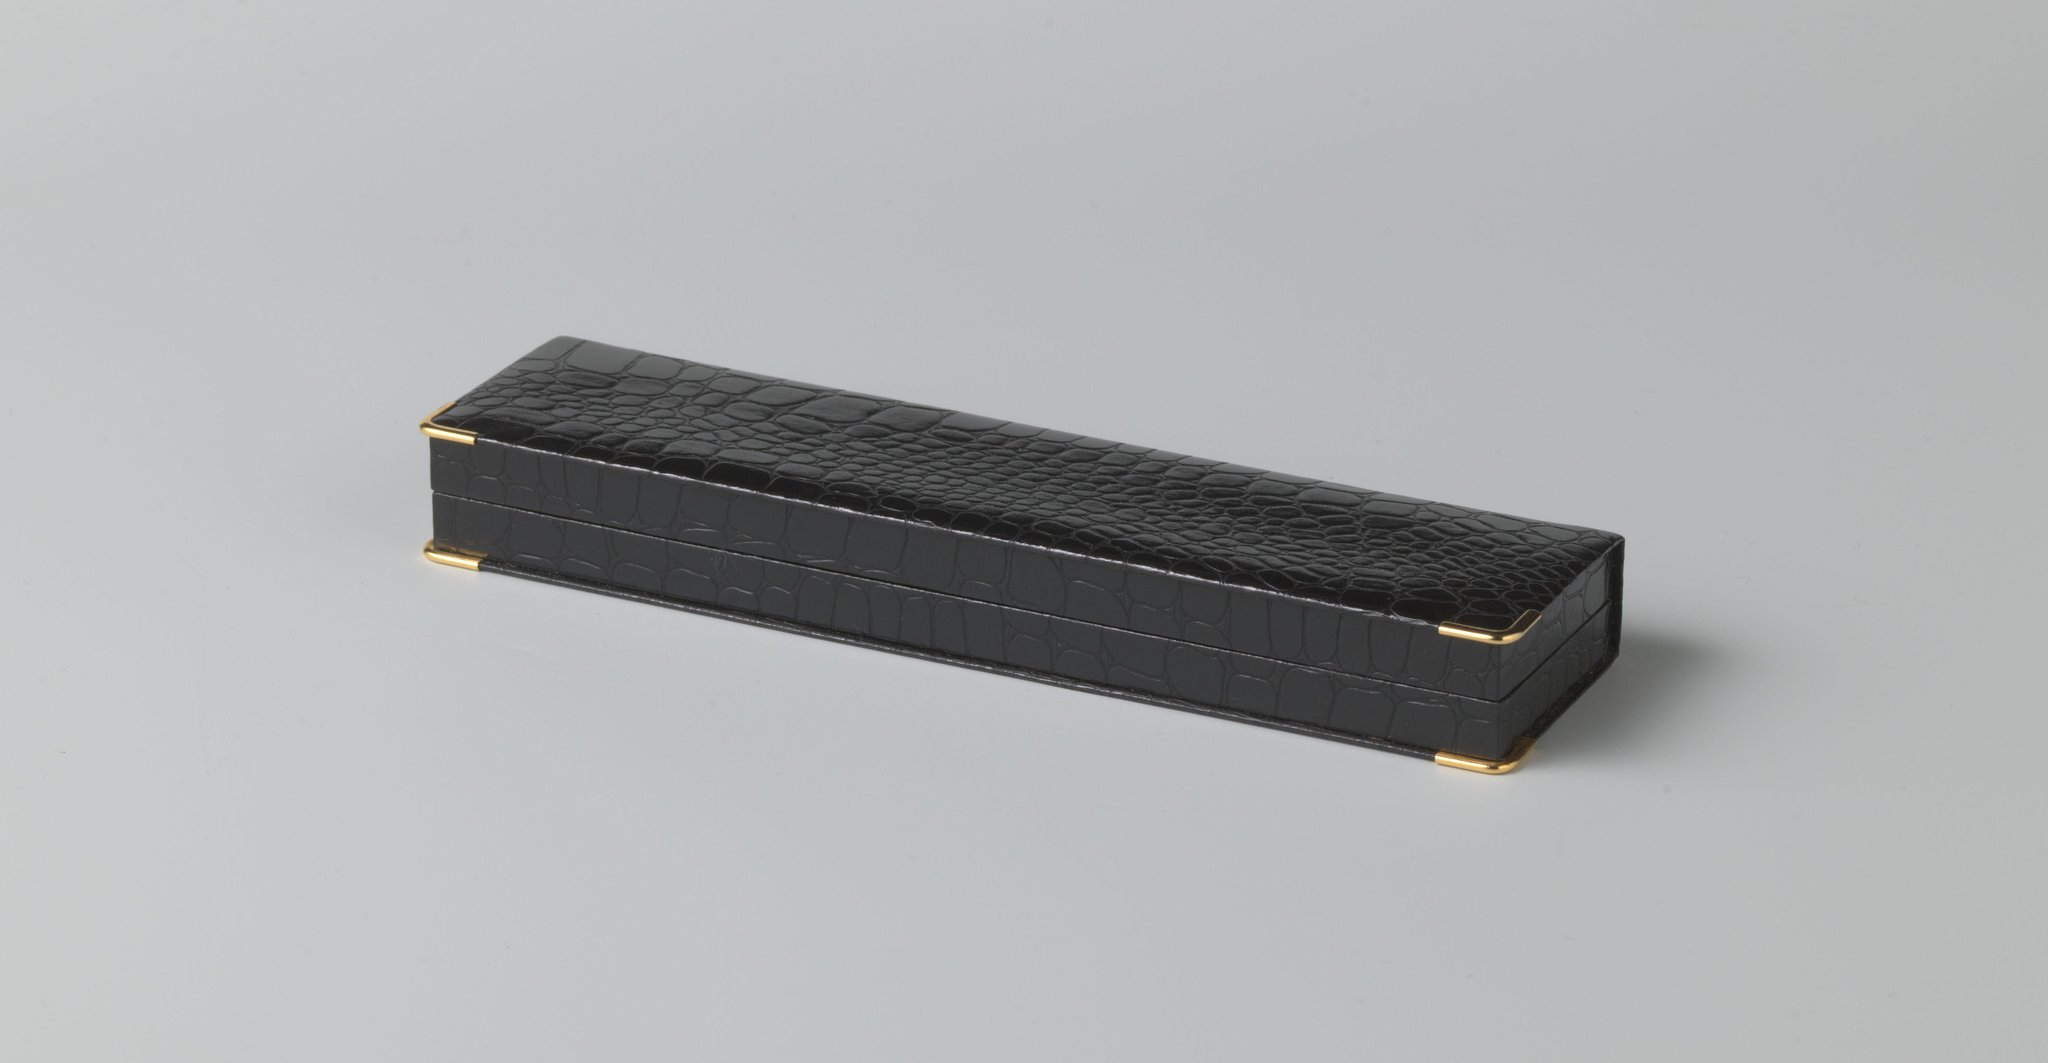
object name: box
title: Doos van sieradenreeks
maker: Anonymous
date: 1940-1945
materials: cardboard, leather, silk, velvet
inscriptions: : ‘REGINA ET PATRIA’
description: Doos van sieradenreeks BK-2010-2-432-.. Zwart (nep)leer met gouden hoeken. Binnenzijde deksel: De Schatkamer HAARLEMMERDIJK 22 AMSTERDAM. Voering van fluweel en zijde.